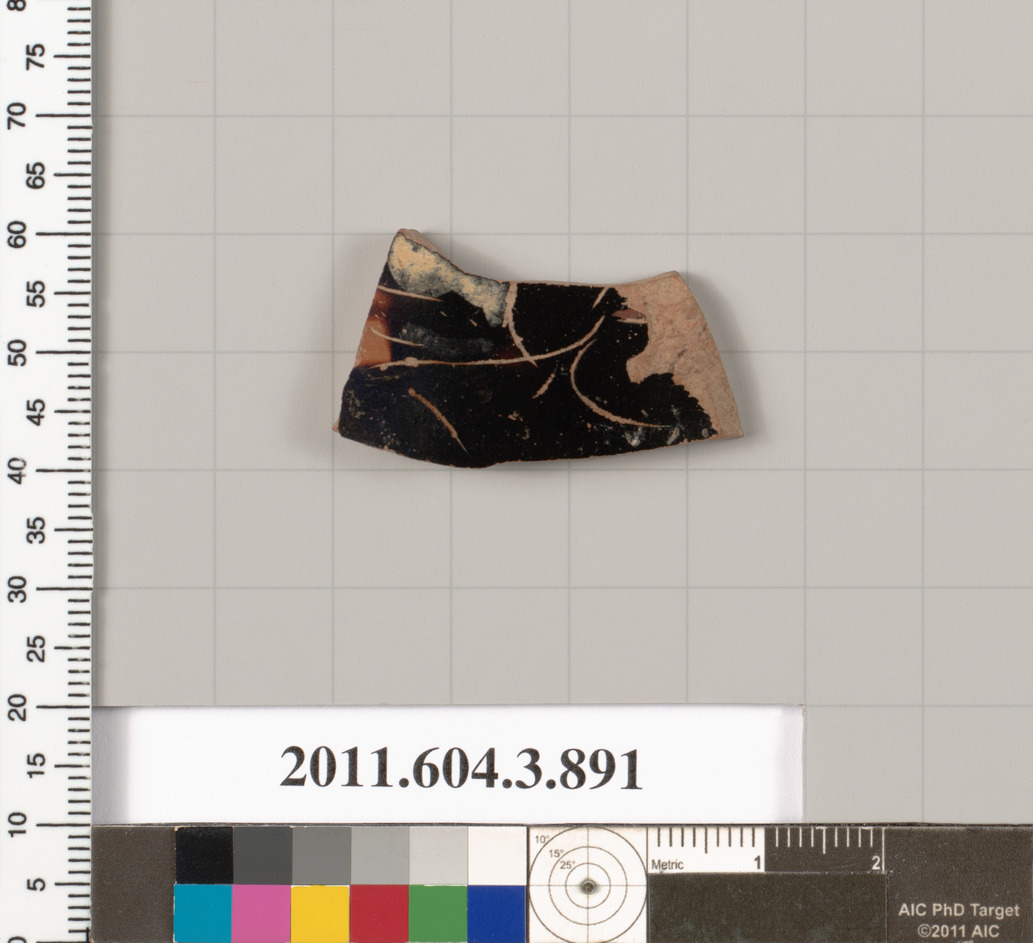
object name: lekythos fragment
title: Terracotta fragment of a lekythos (oil flask)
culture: greek, attic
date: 534-468 BCE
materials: terracotta